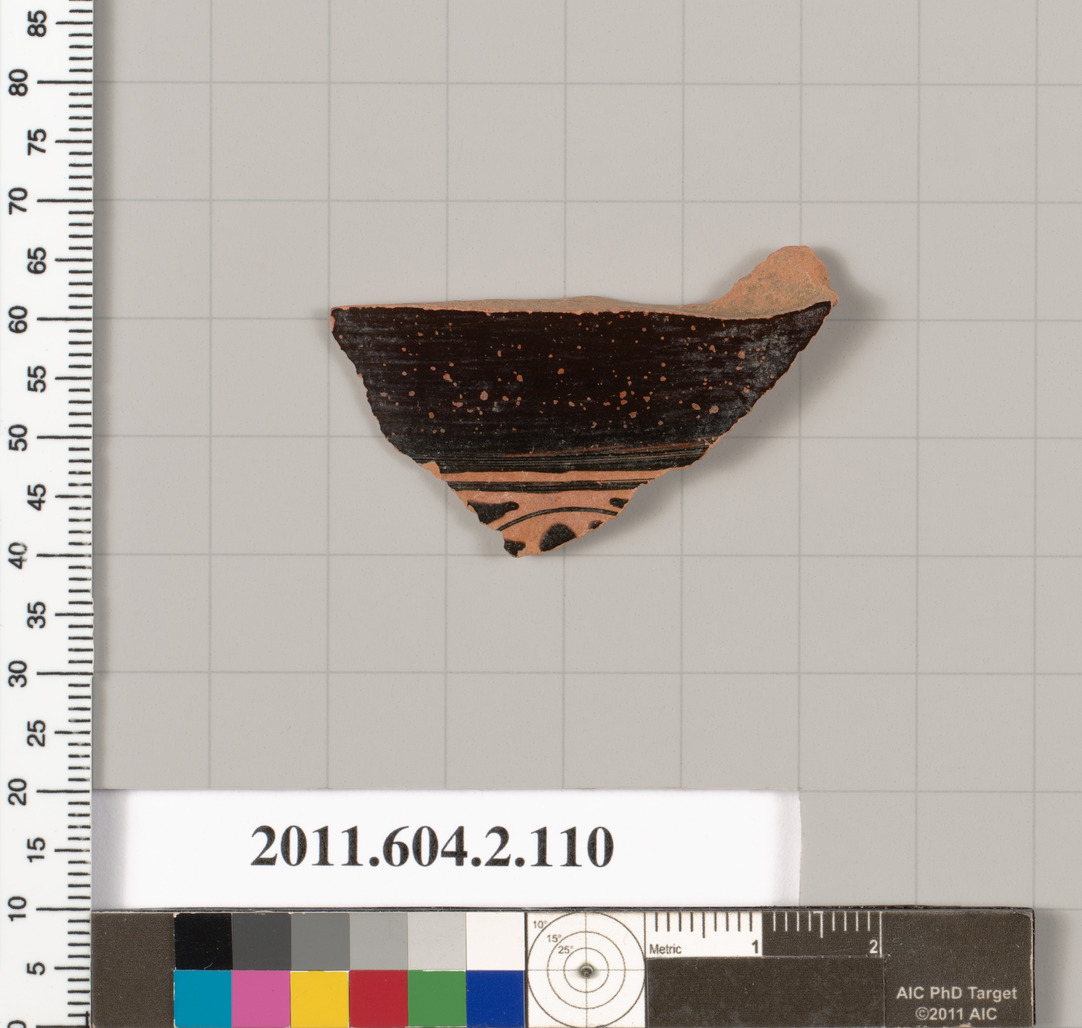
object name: pelike fragment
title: Terracotta fragment of a pelike (jar)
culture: greek, attic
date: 520-500 BCE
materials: terracotta